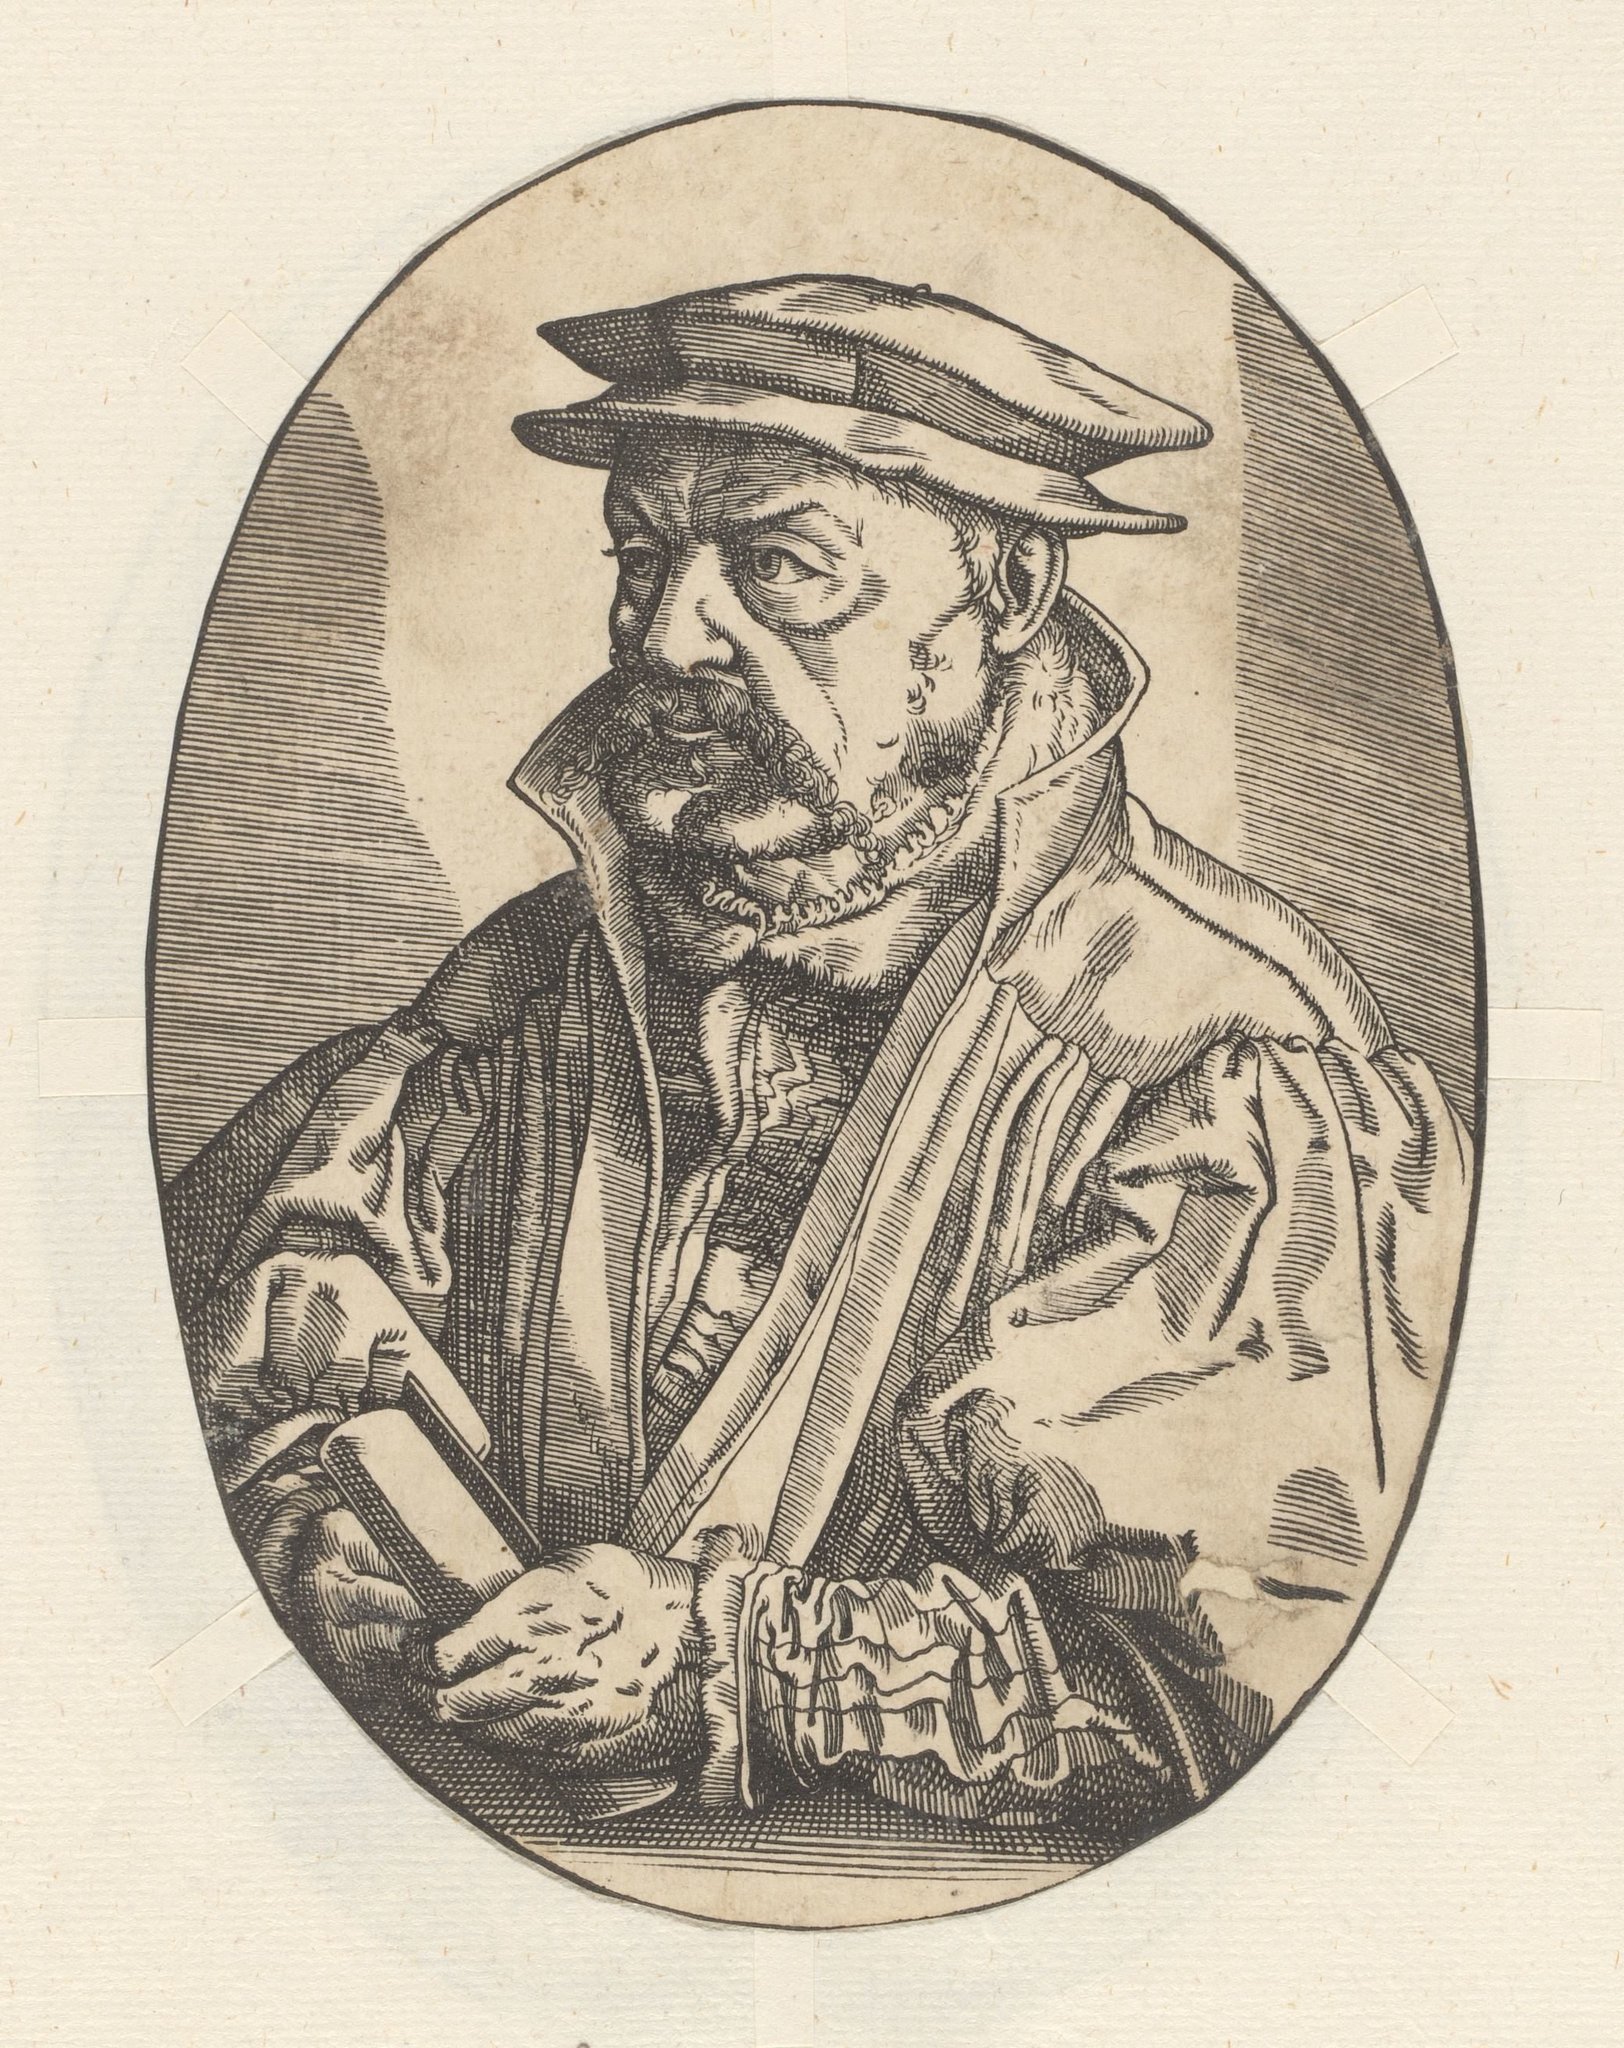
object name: album leaf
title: Portret van een onbekende man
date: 1549-1584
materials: paper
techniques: woodcut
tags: historical persons